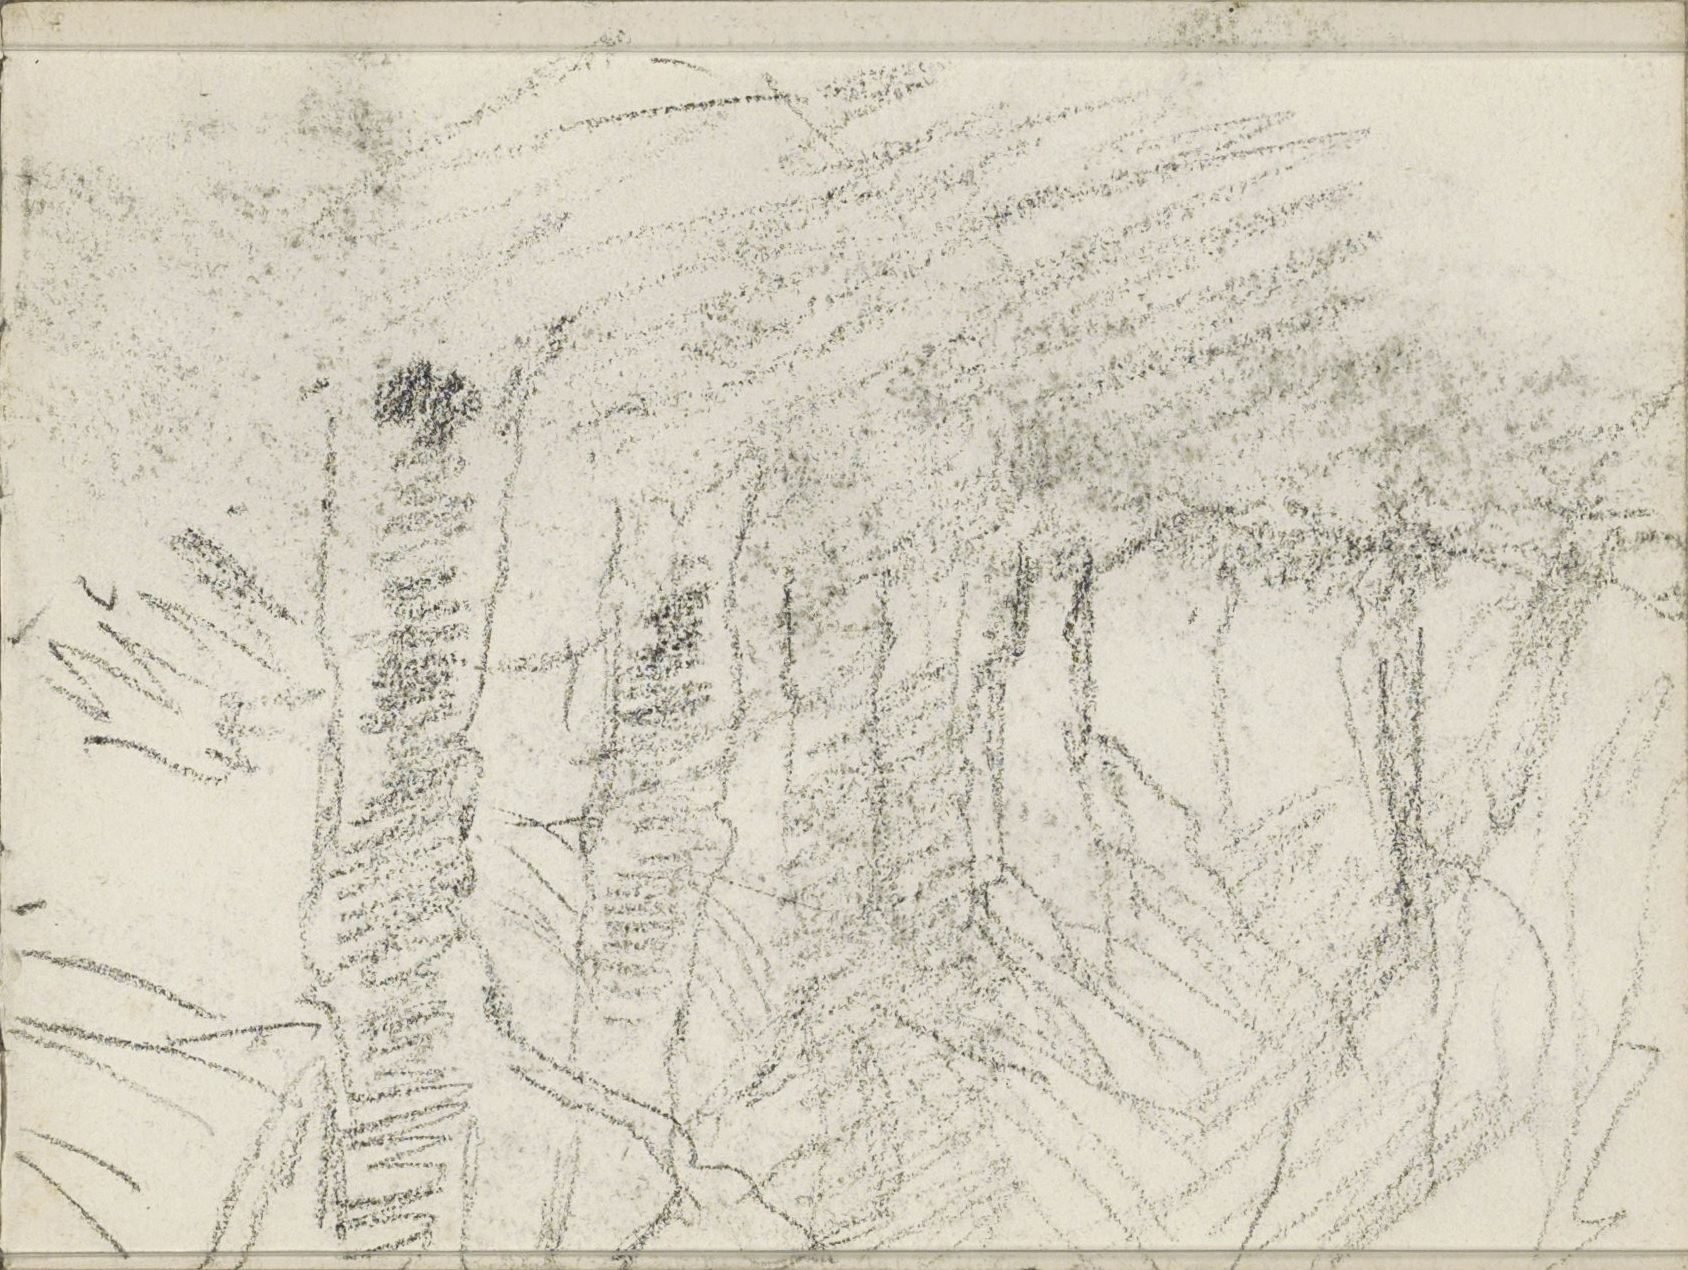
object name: sketchbook leaf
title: Boomstammen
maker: anton mauve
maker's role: draughtsman, painter, print maker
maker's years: 1838-1888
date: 1881-1888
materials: chalk, paper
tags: trees (+ stem, trunk)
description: Blad 25 recto uit een schetsboek met 29 bladen.